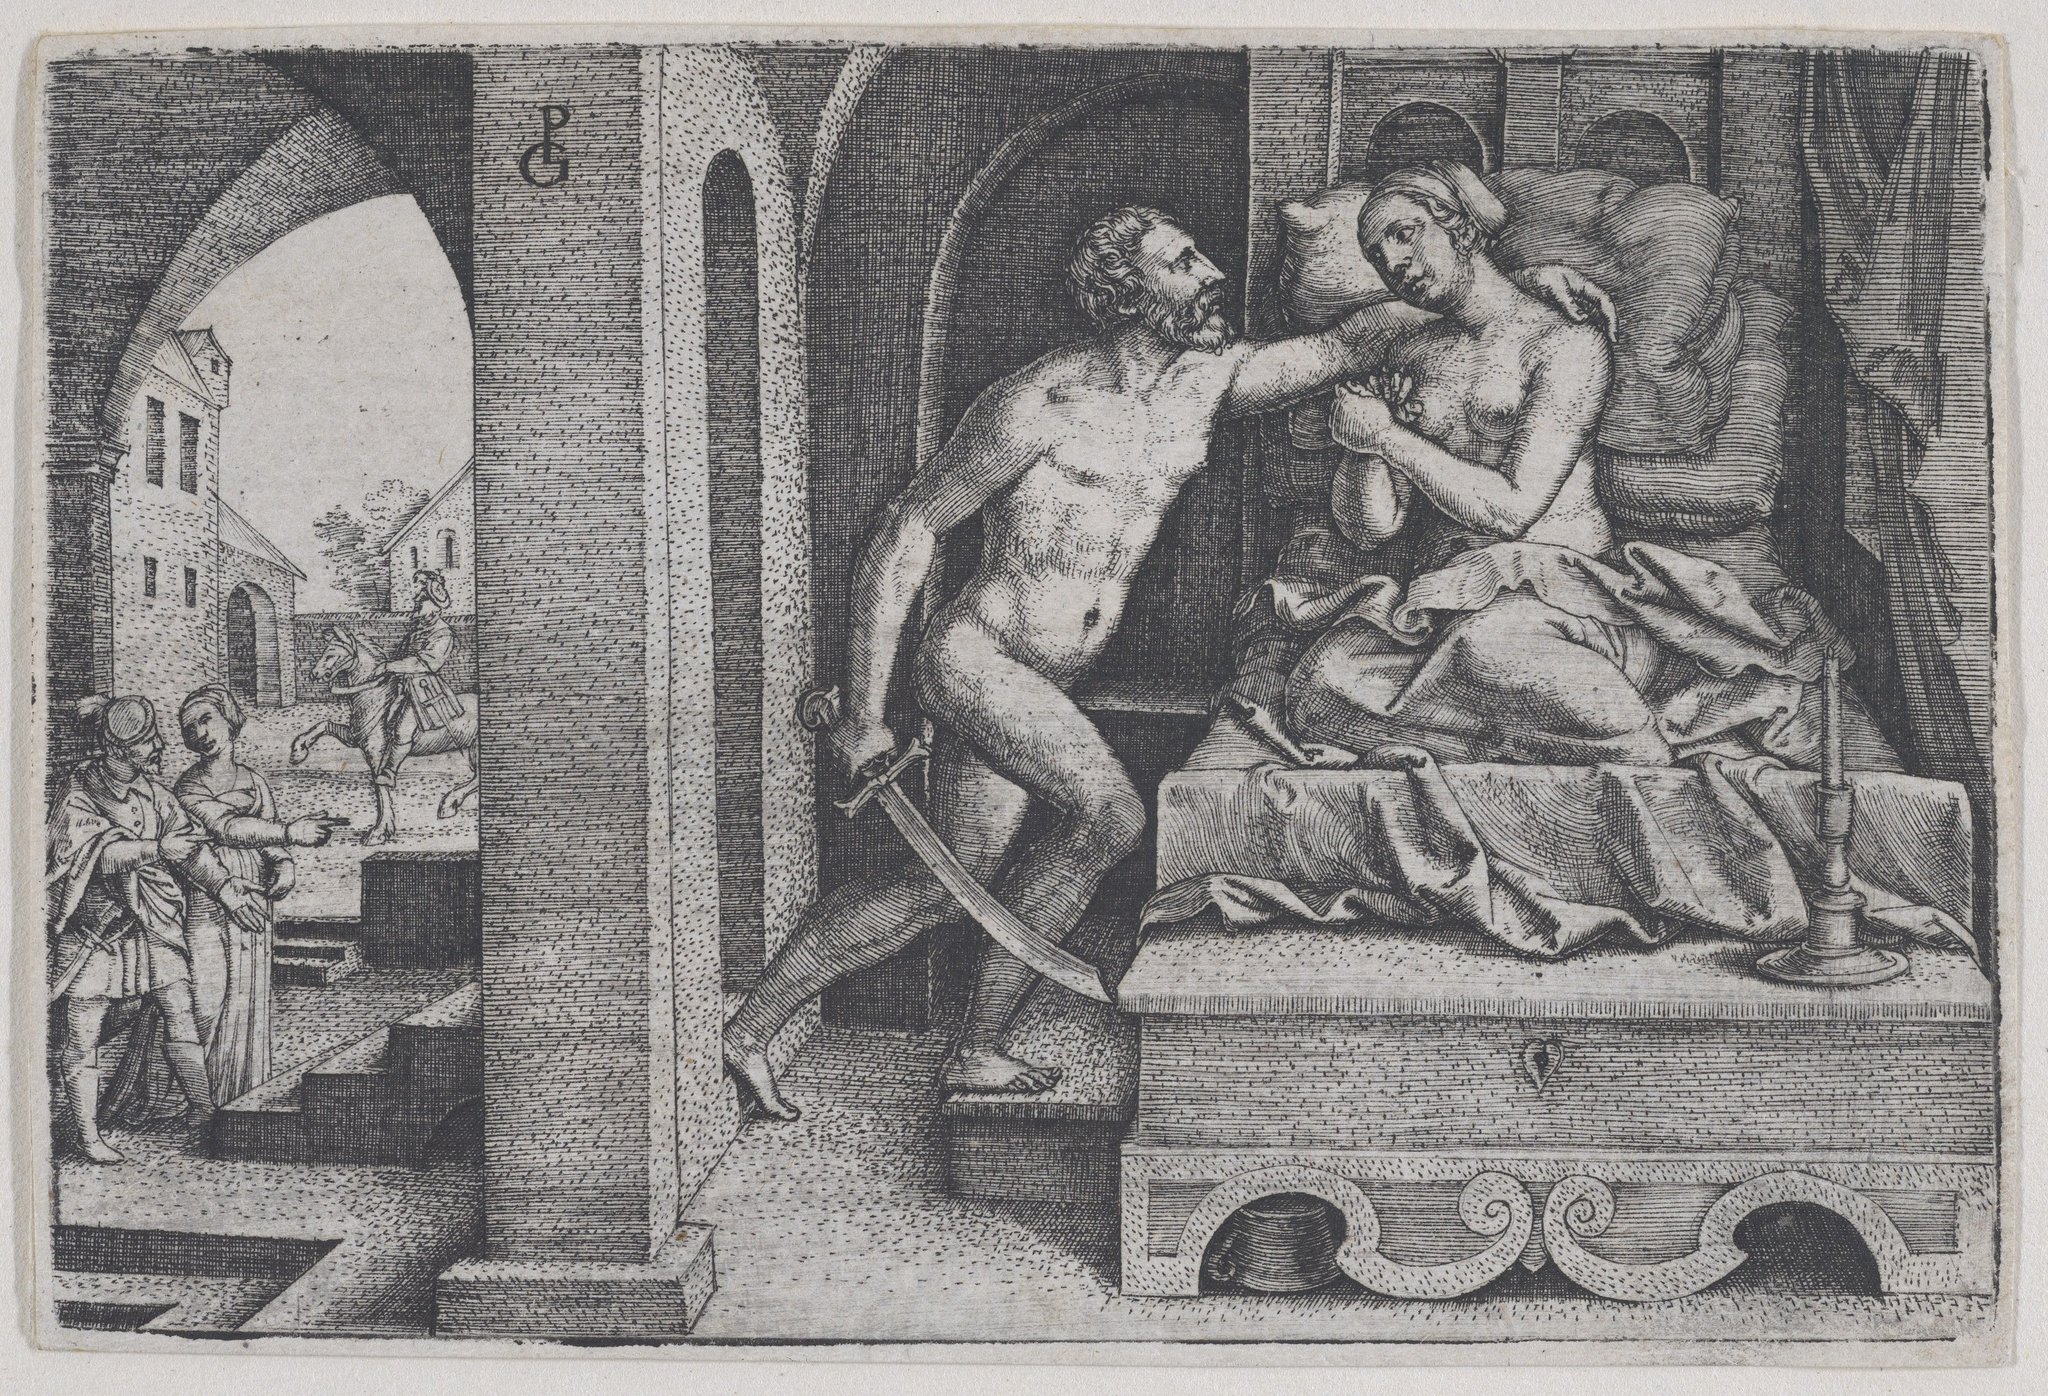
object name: print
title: Tarquinius Rapes Lucretia, from Scenes from Roman History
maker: georg pencz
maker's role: artist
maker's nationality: german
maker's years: 1500-1550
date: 1541-1552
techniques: engraving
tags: swords,kings,male nudes,female nudes